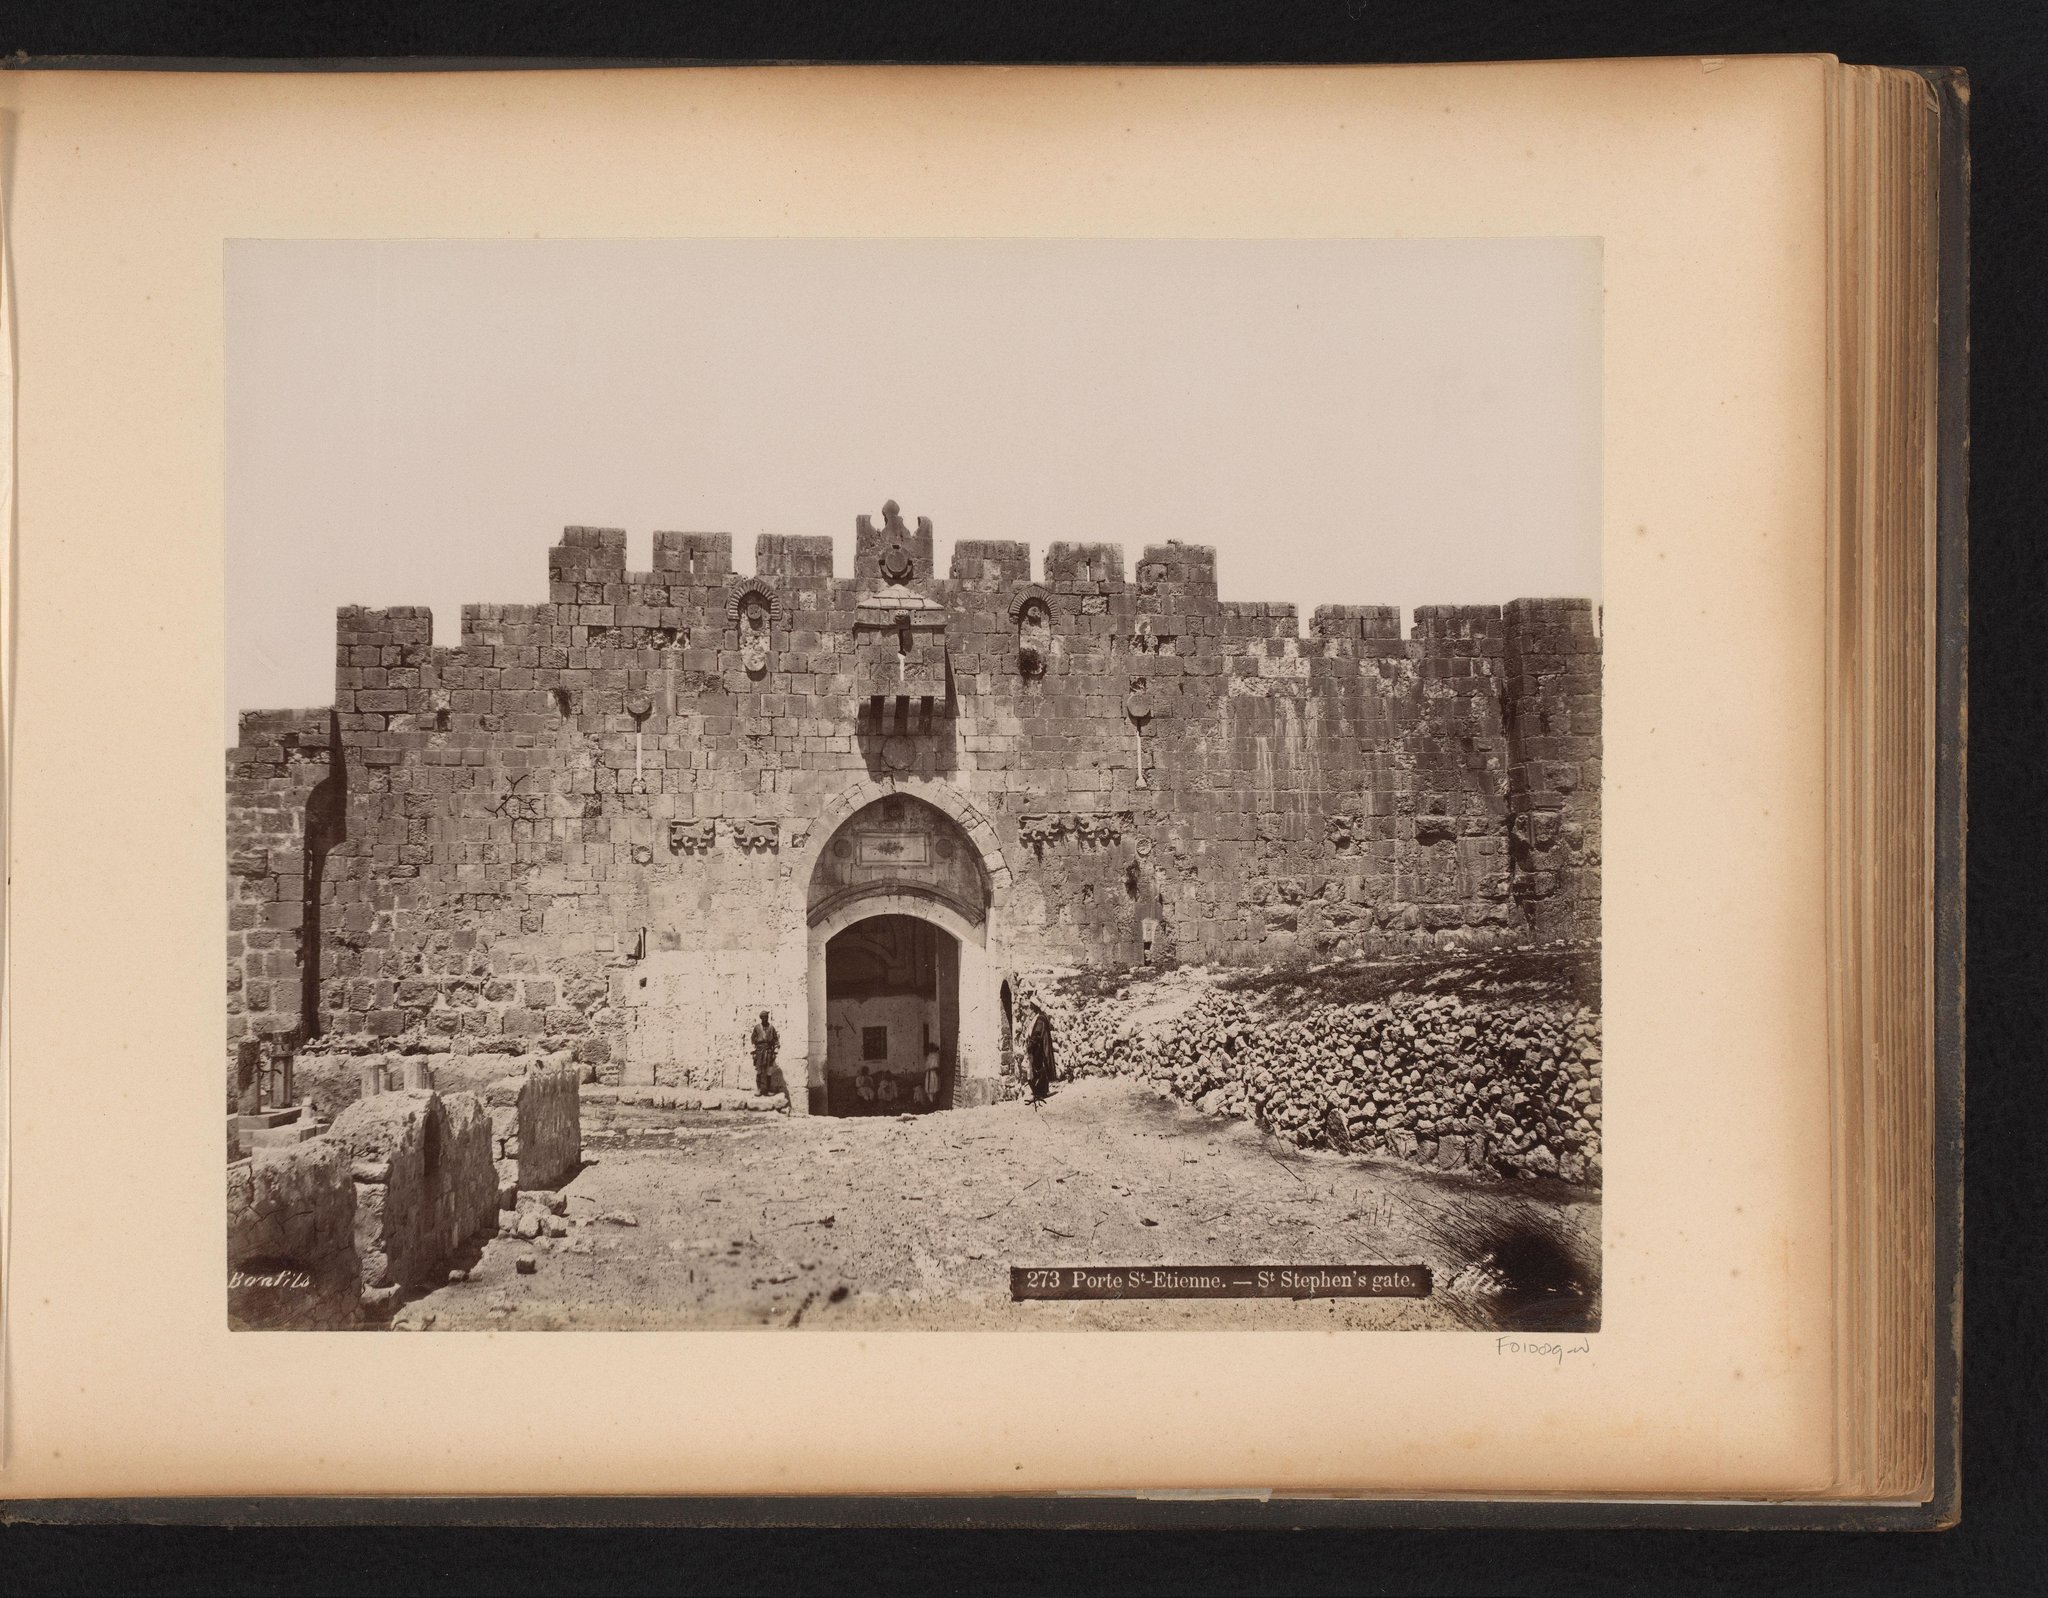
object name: photograph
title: Leeuwenpoort in Jeruzalem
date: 1867-1895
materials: cardboard, paper, photographic support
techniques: albumen print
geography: jerusalem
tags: gate, entrance, city-walls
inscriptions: inscription: ‘T&M B.F.K. Rives No. 74.’, negative number: ‘273’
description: Onderdeel van Reisalbum met foto's van Jeruzalem en andere bijbelse plaatsen.